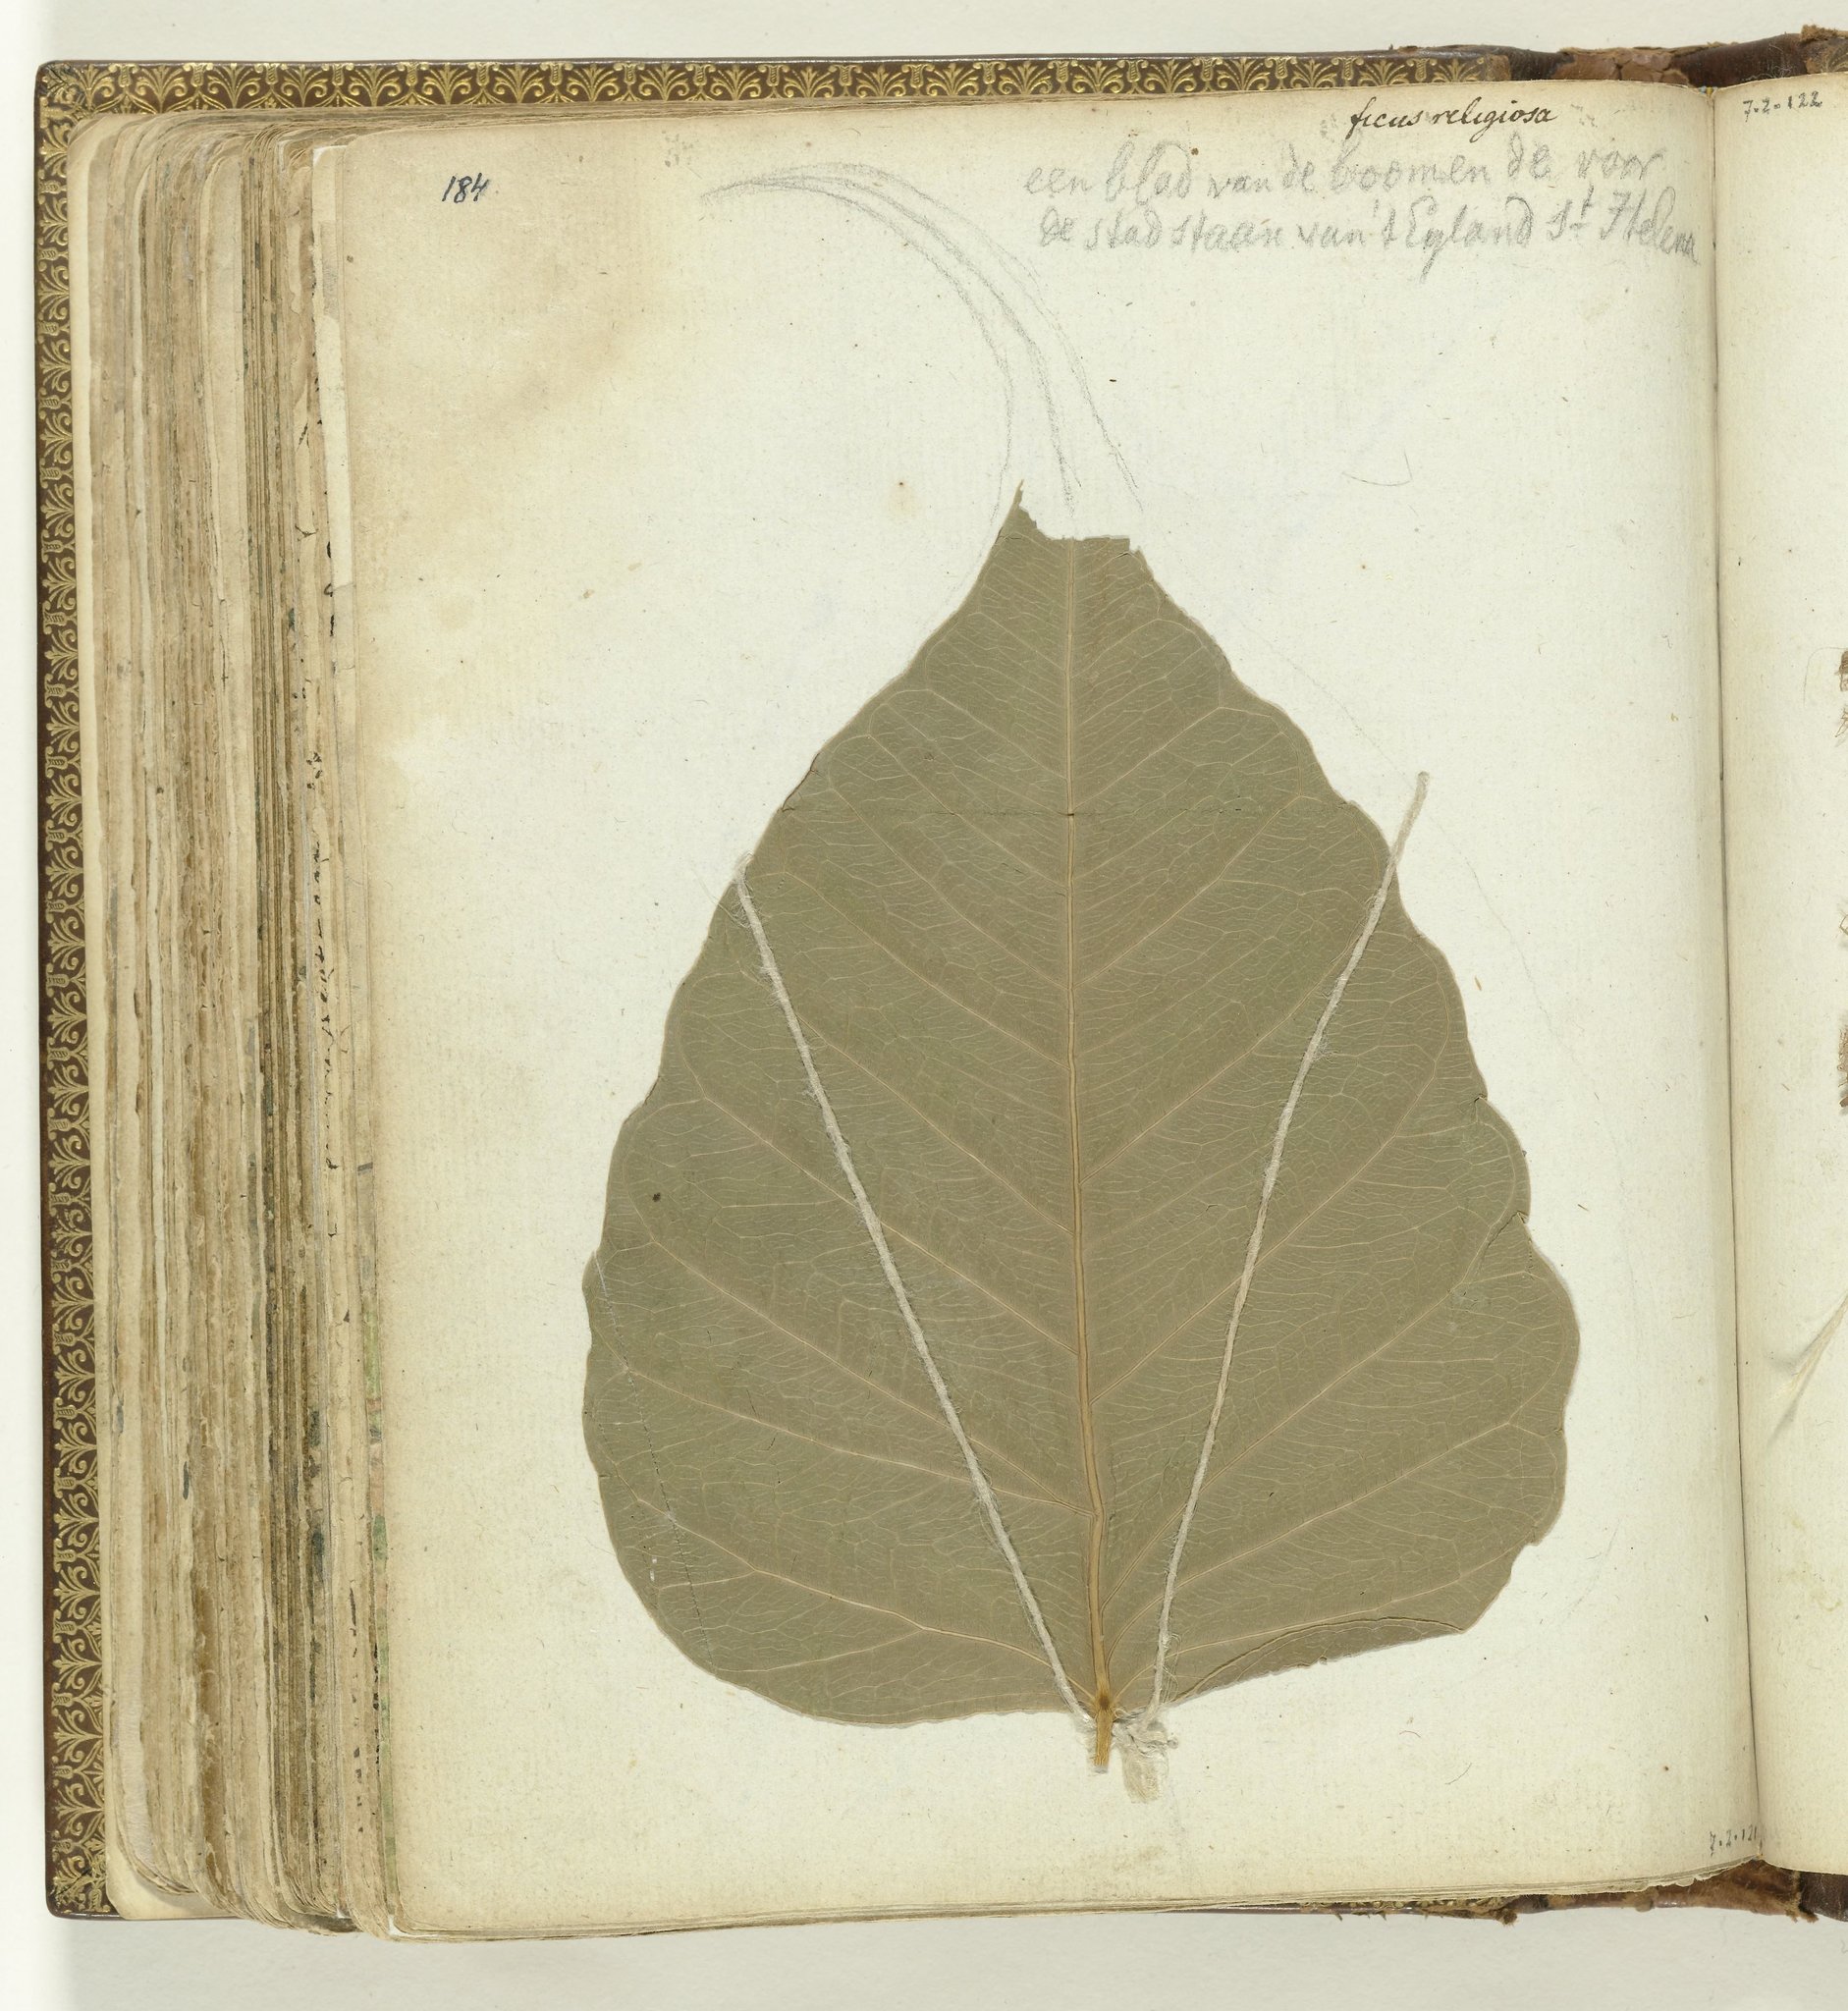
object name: album leaf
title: Boomblad Sint-Helena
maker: jan brandes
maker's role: draughtsman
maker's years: 1743-1808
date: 1787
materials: paper, pencil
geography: sint-helena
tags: trees (+ leaf)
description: Potloodschets aan een gedroogd blad dat met touw aan het papier is vastgenaaid. het blad is van een boom bij de stad op Sint-Helena. Met opschrift. Onderdeel uit het schetsboek van Jan Brandes, dl. 2 (1808), p. 184.